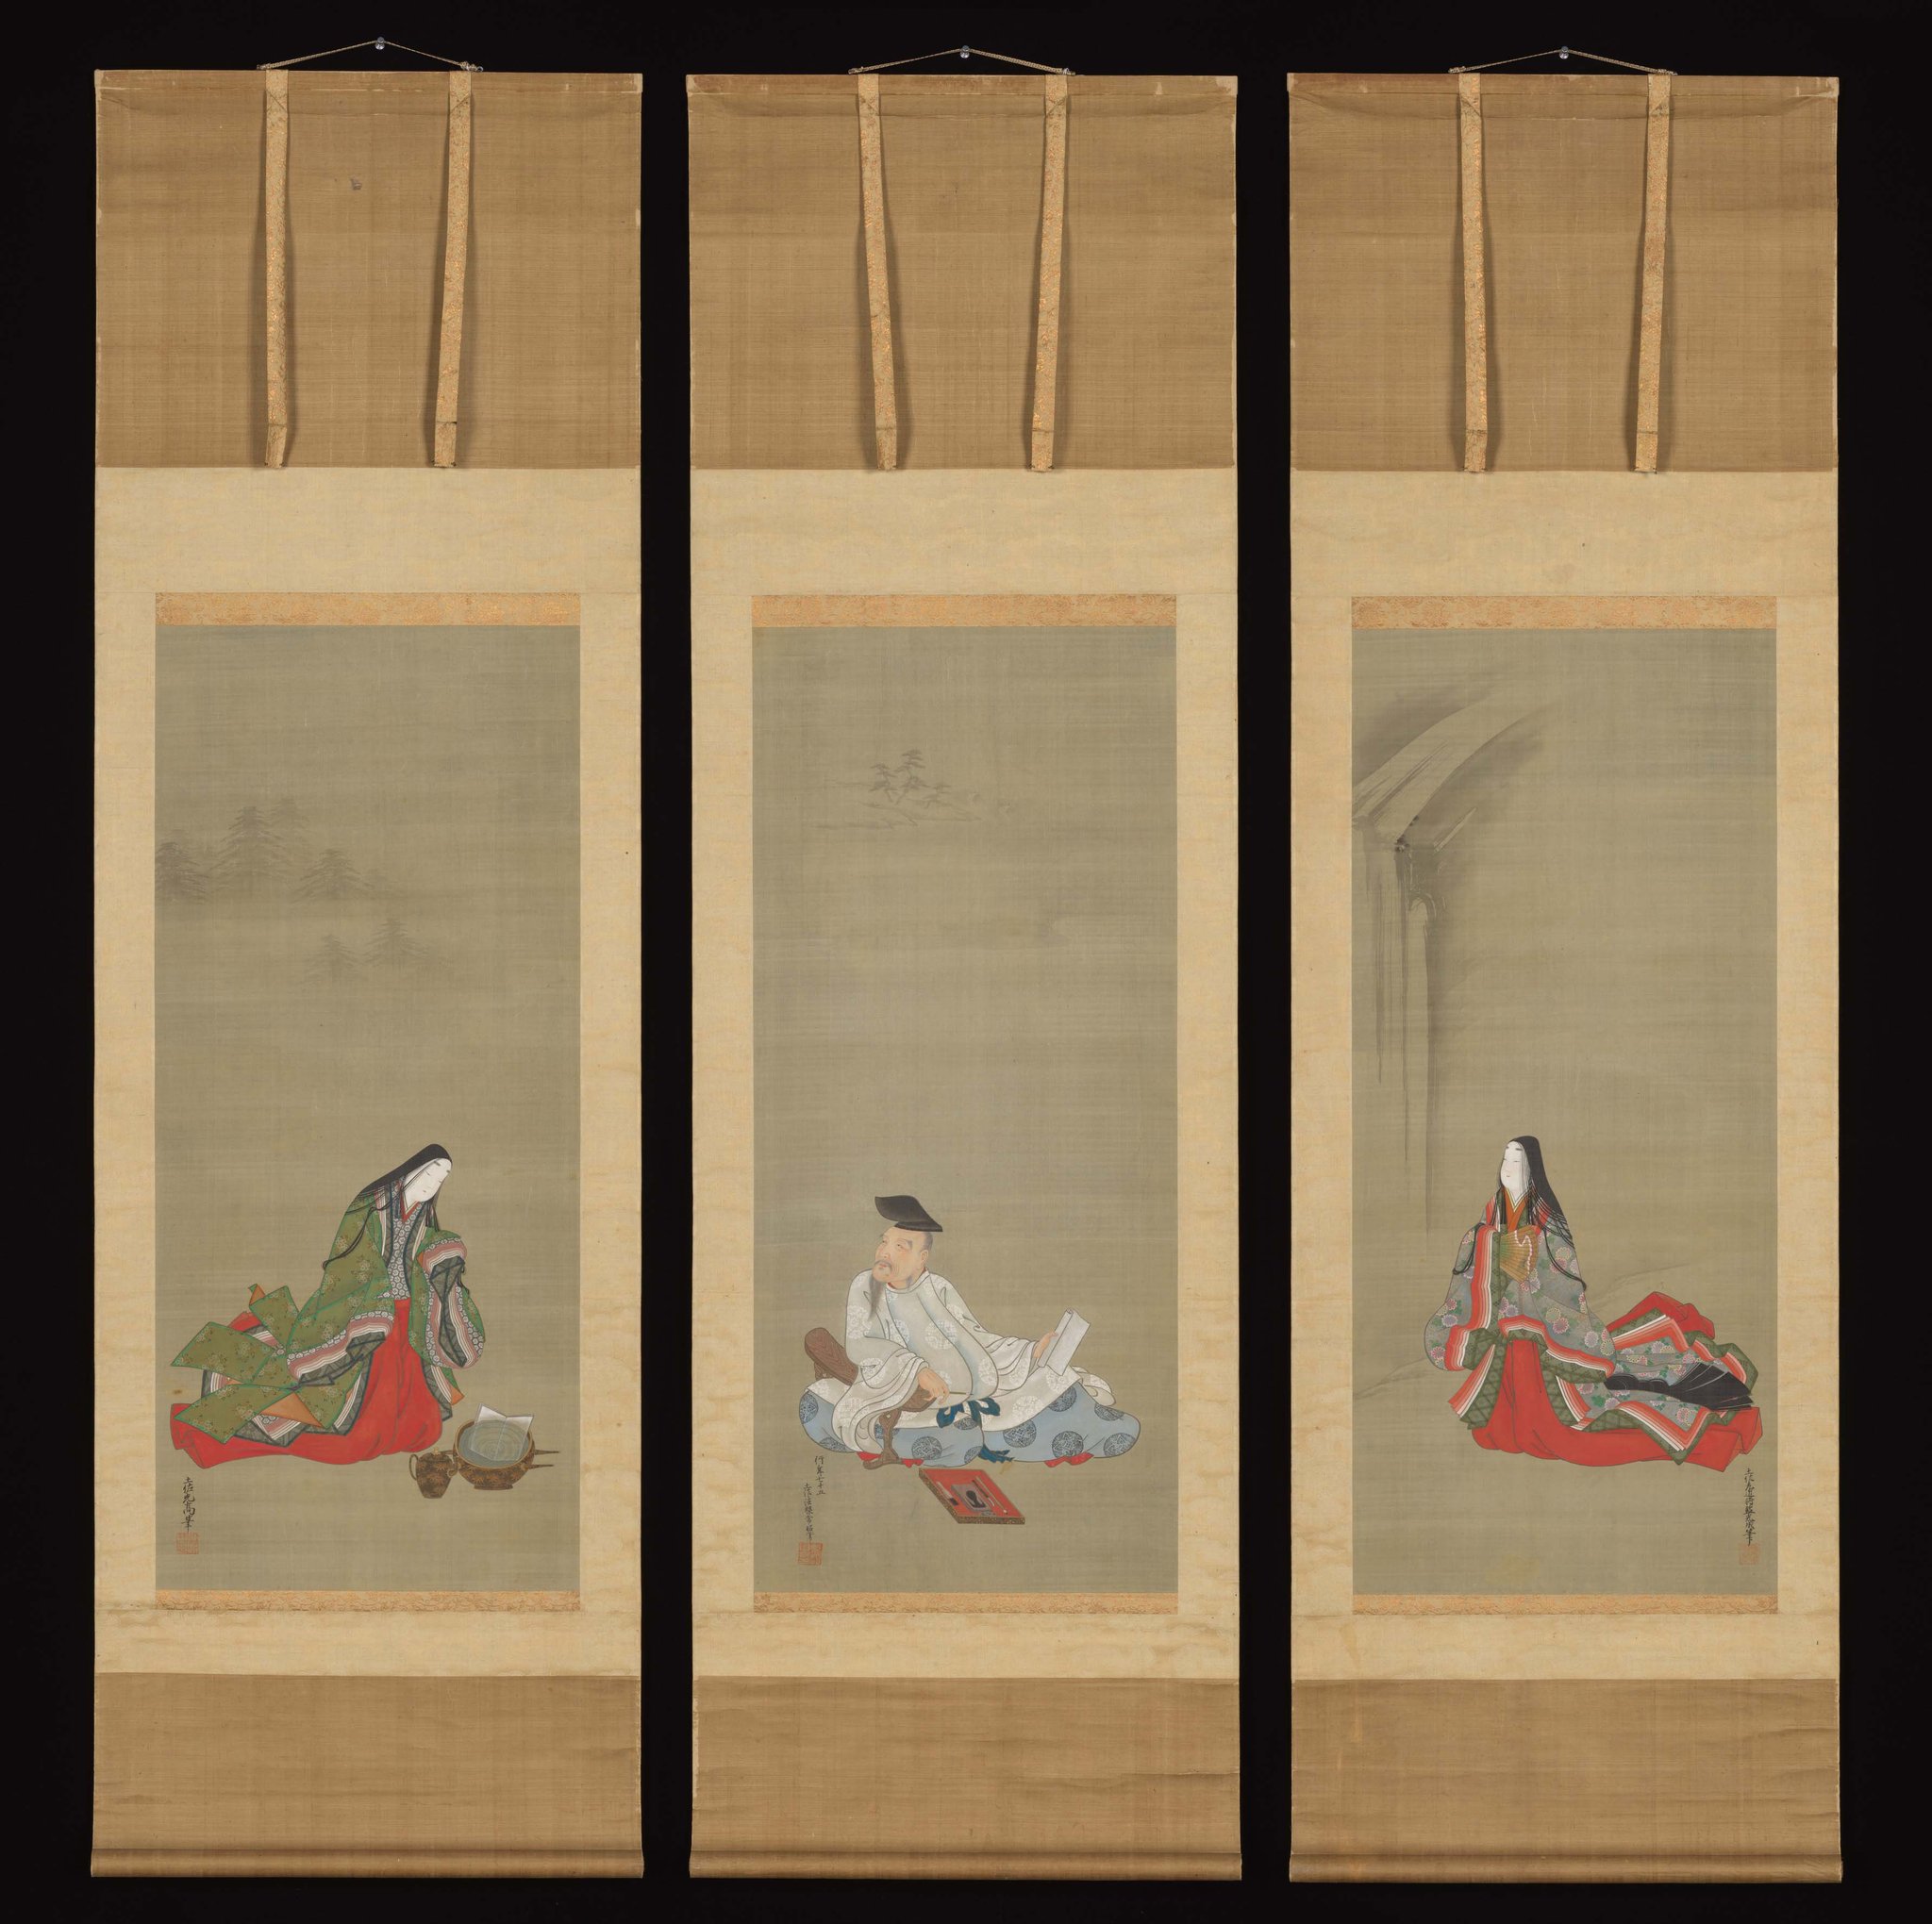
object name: hanging scroll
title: Portraits of Three Famous Poets: Kakinomoto no Hitomaro, Lady Ise, and Ono no Komachi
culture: japanese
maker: tosa mitsuoki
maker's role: artist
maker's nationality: japanese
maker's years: 1617-1691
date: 1691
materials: gold, ink, silk, silver